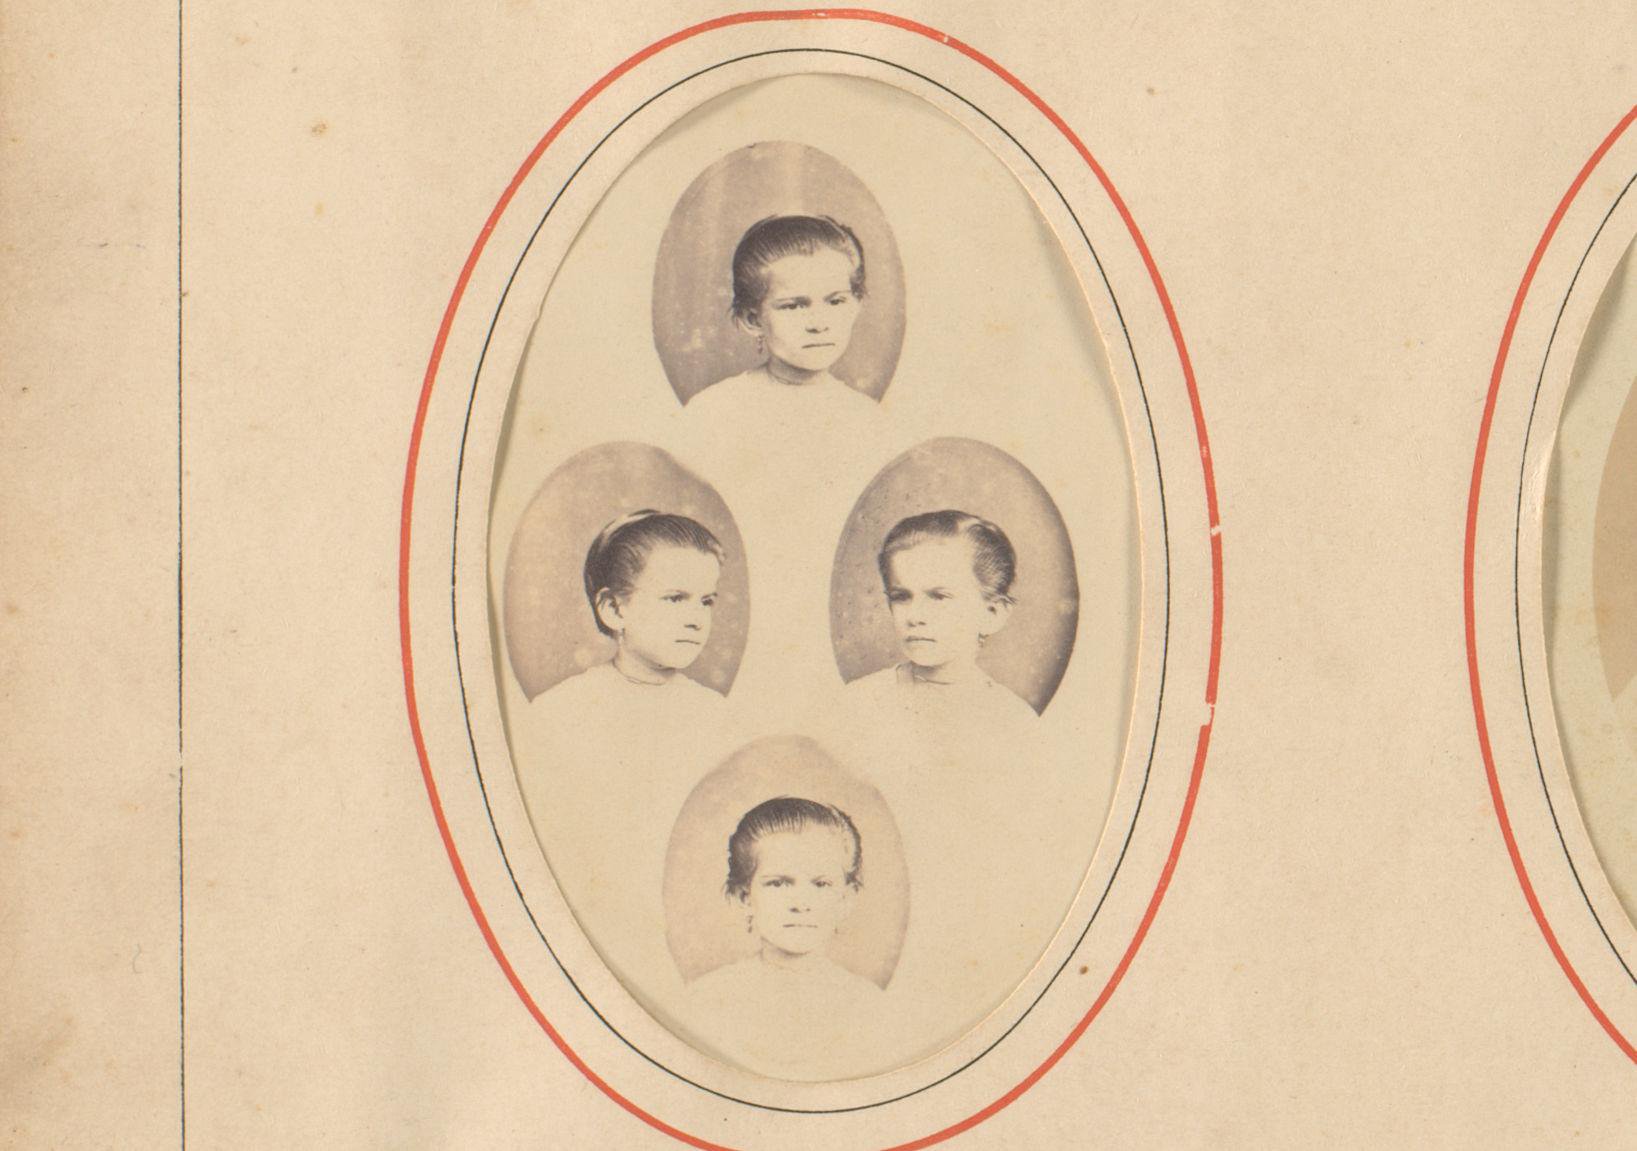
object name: photograph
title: Vier portretten van een onbekend meisje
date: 1870-1890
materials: cardboard, paper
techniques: albumen print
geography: batavia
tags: anonymous historical person portrayed - bb - woman